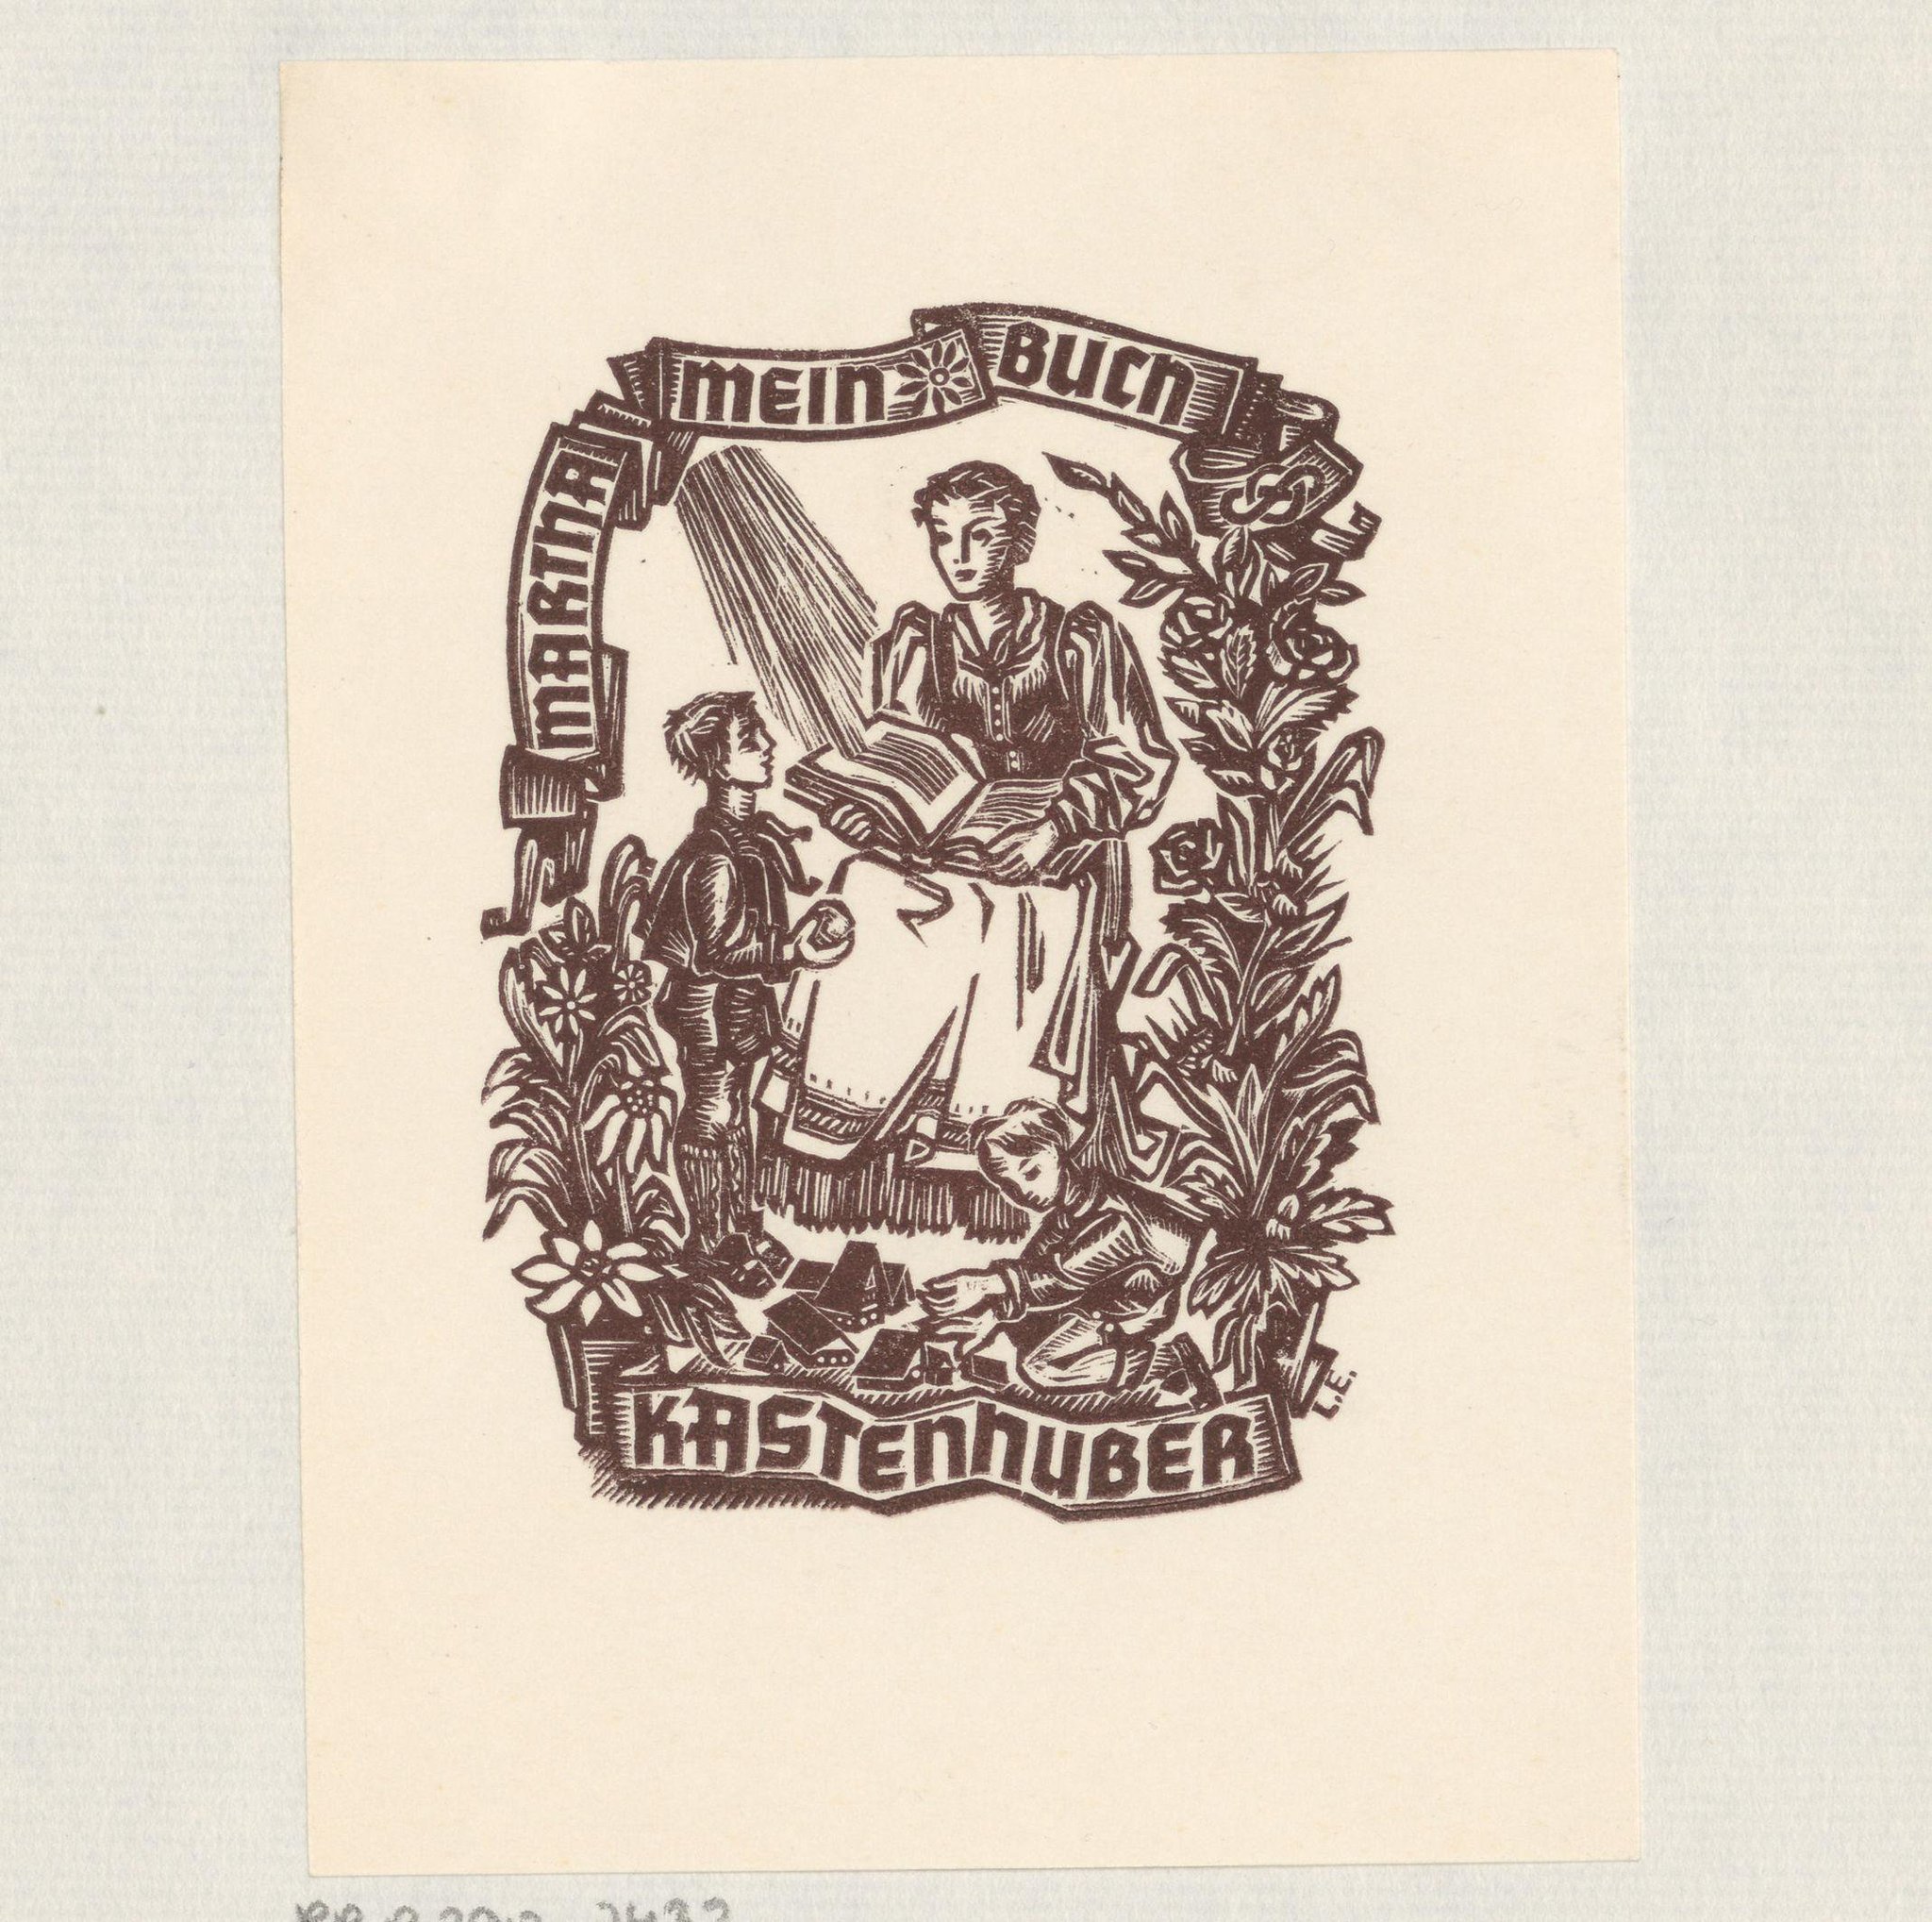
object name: bookplate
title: Mein Buch/ Martha/ Kastenhuber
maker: liesl enzenhofer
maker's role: print maker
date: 1900-1949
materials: paper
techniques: woodcut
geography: austria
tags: flowers, book, mother and child(ren), woman and child(ren) (family group)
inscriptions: handgeschreven